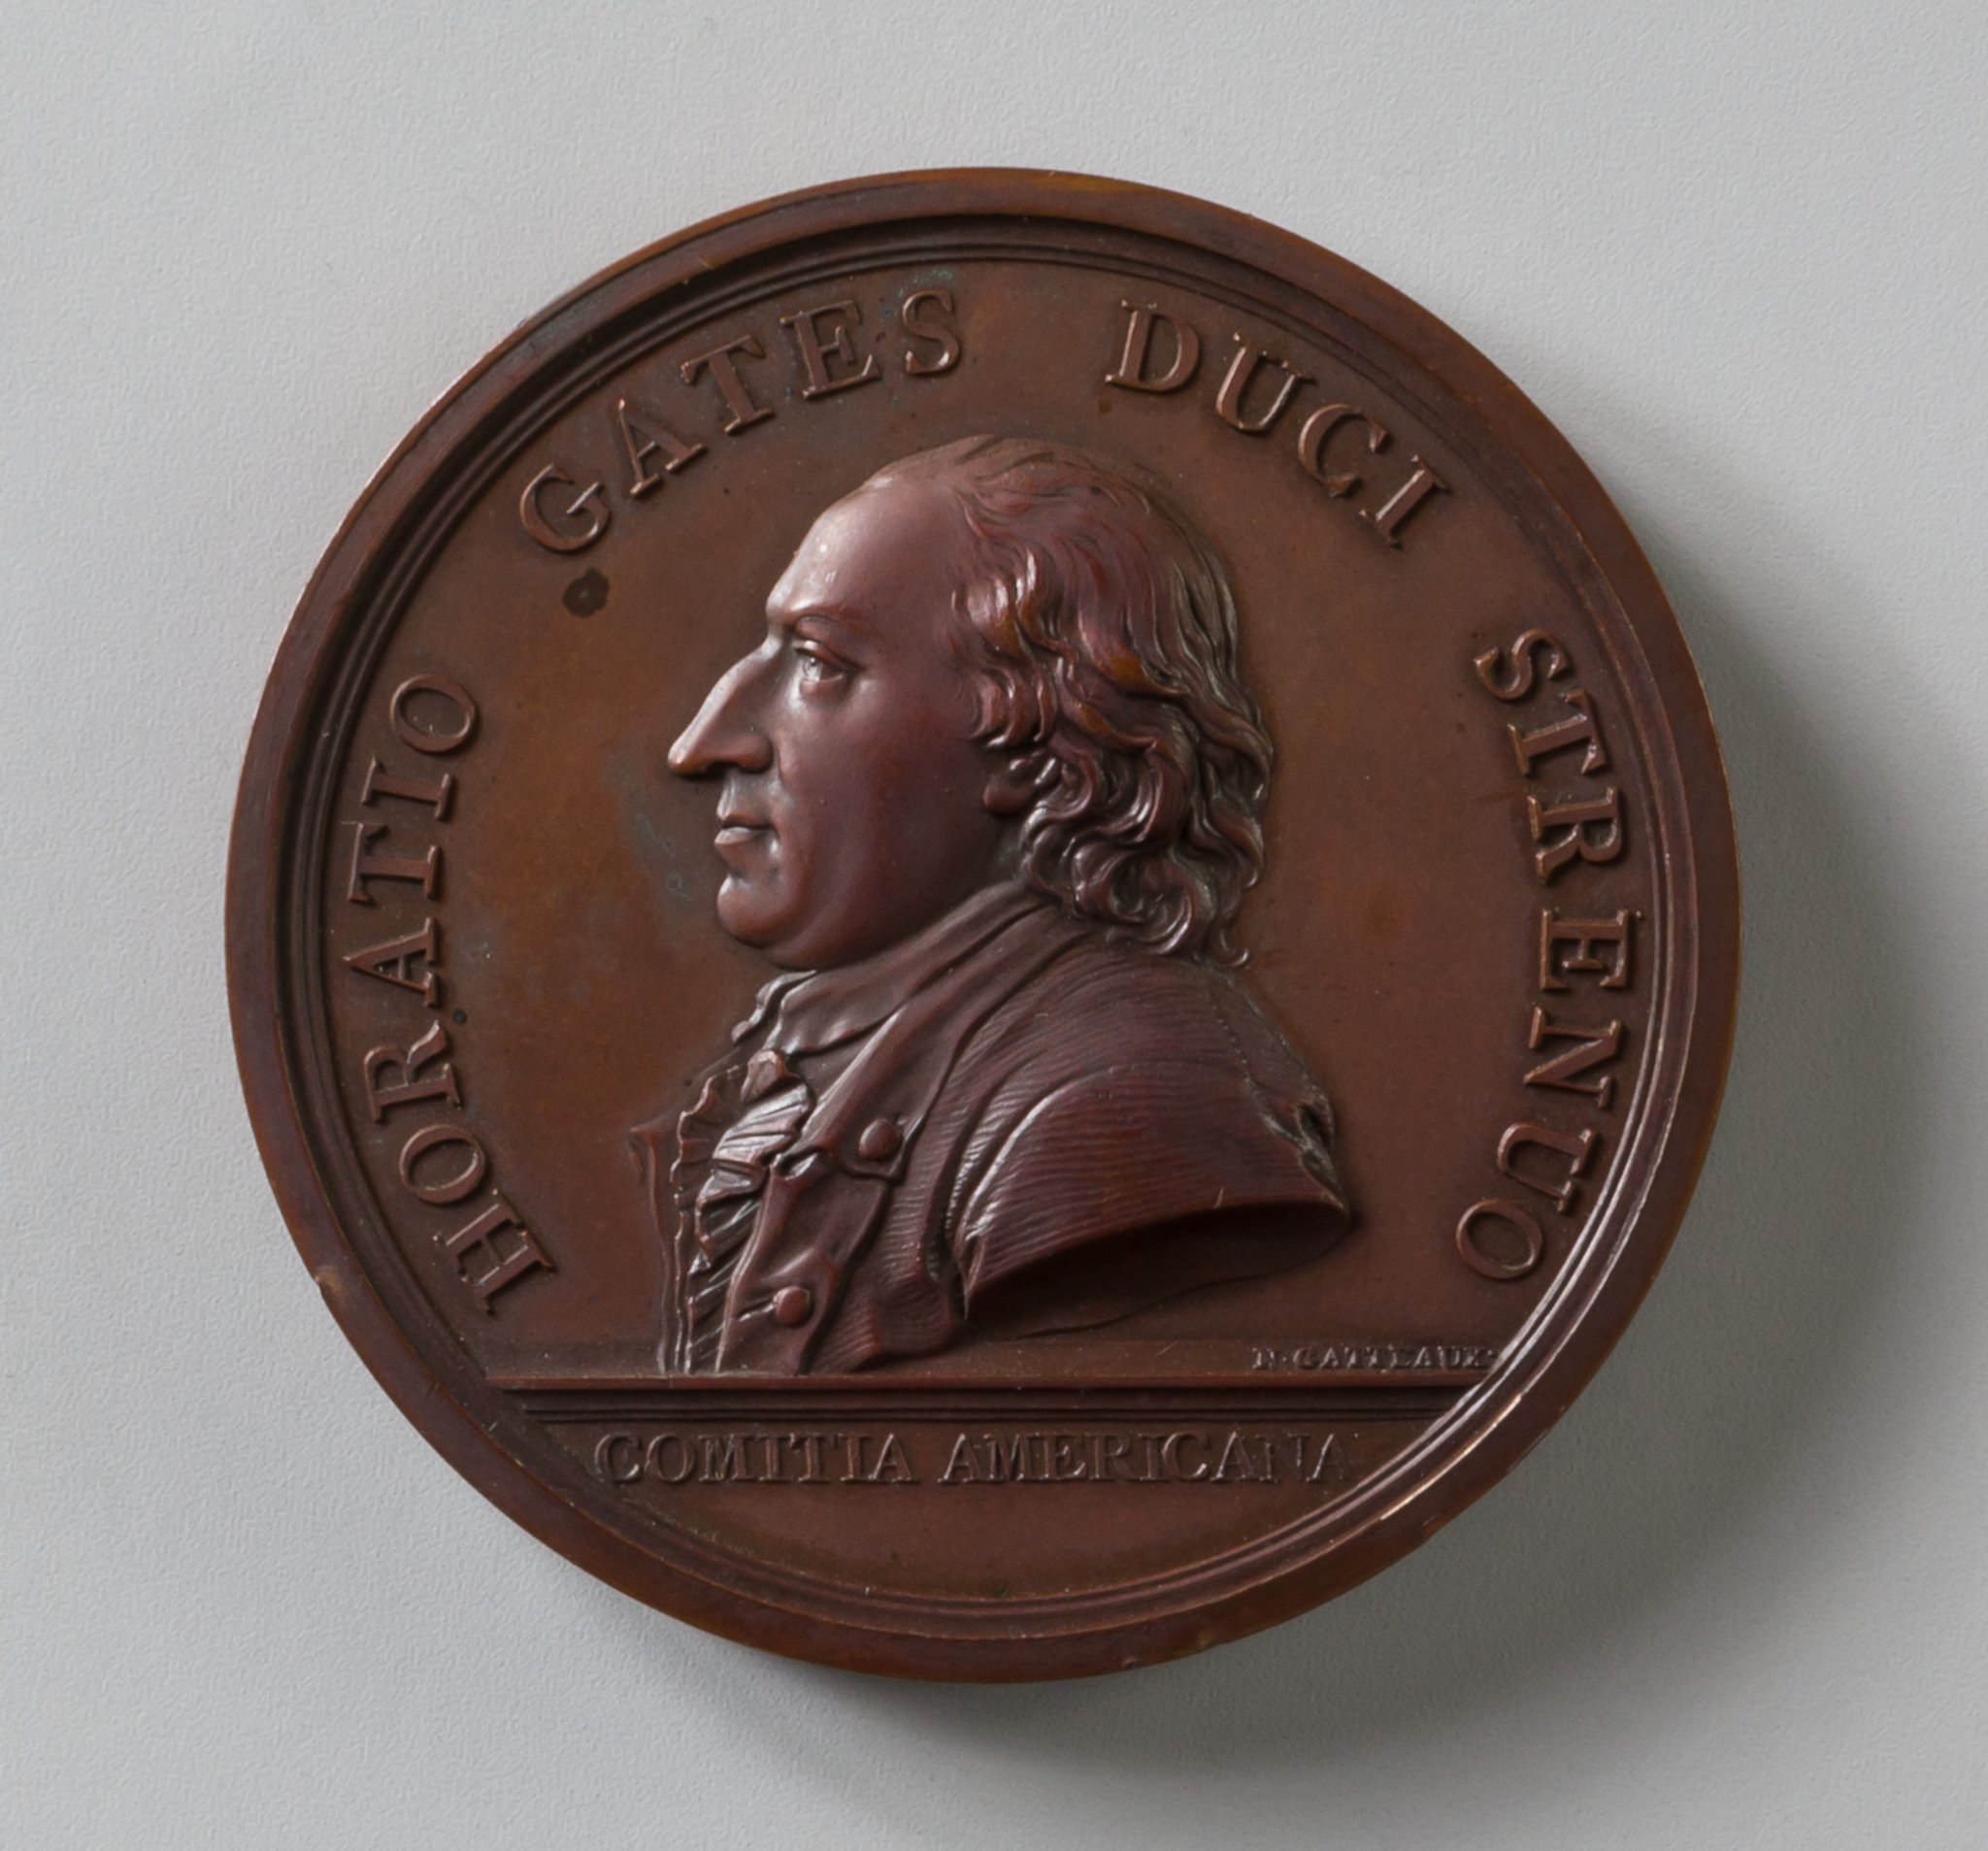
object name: medal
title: Medal of Gates at Saratoga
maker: nicolas marie gatteaux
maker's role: maker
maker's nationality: french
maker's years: 1751-1832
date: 1777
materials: bronze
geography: france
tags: military,swords,men,profiles